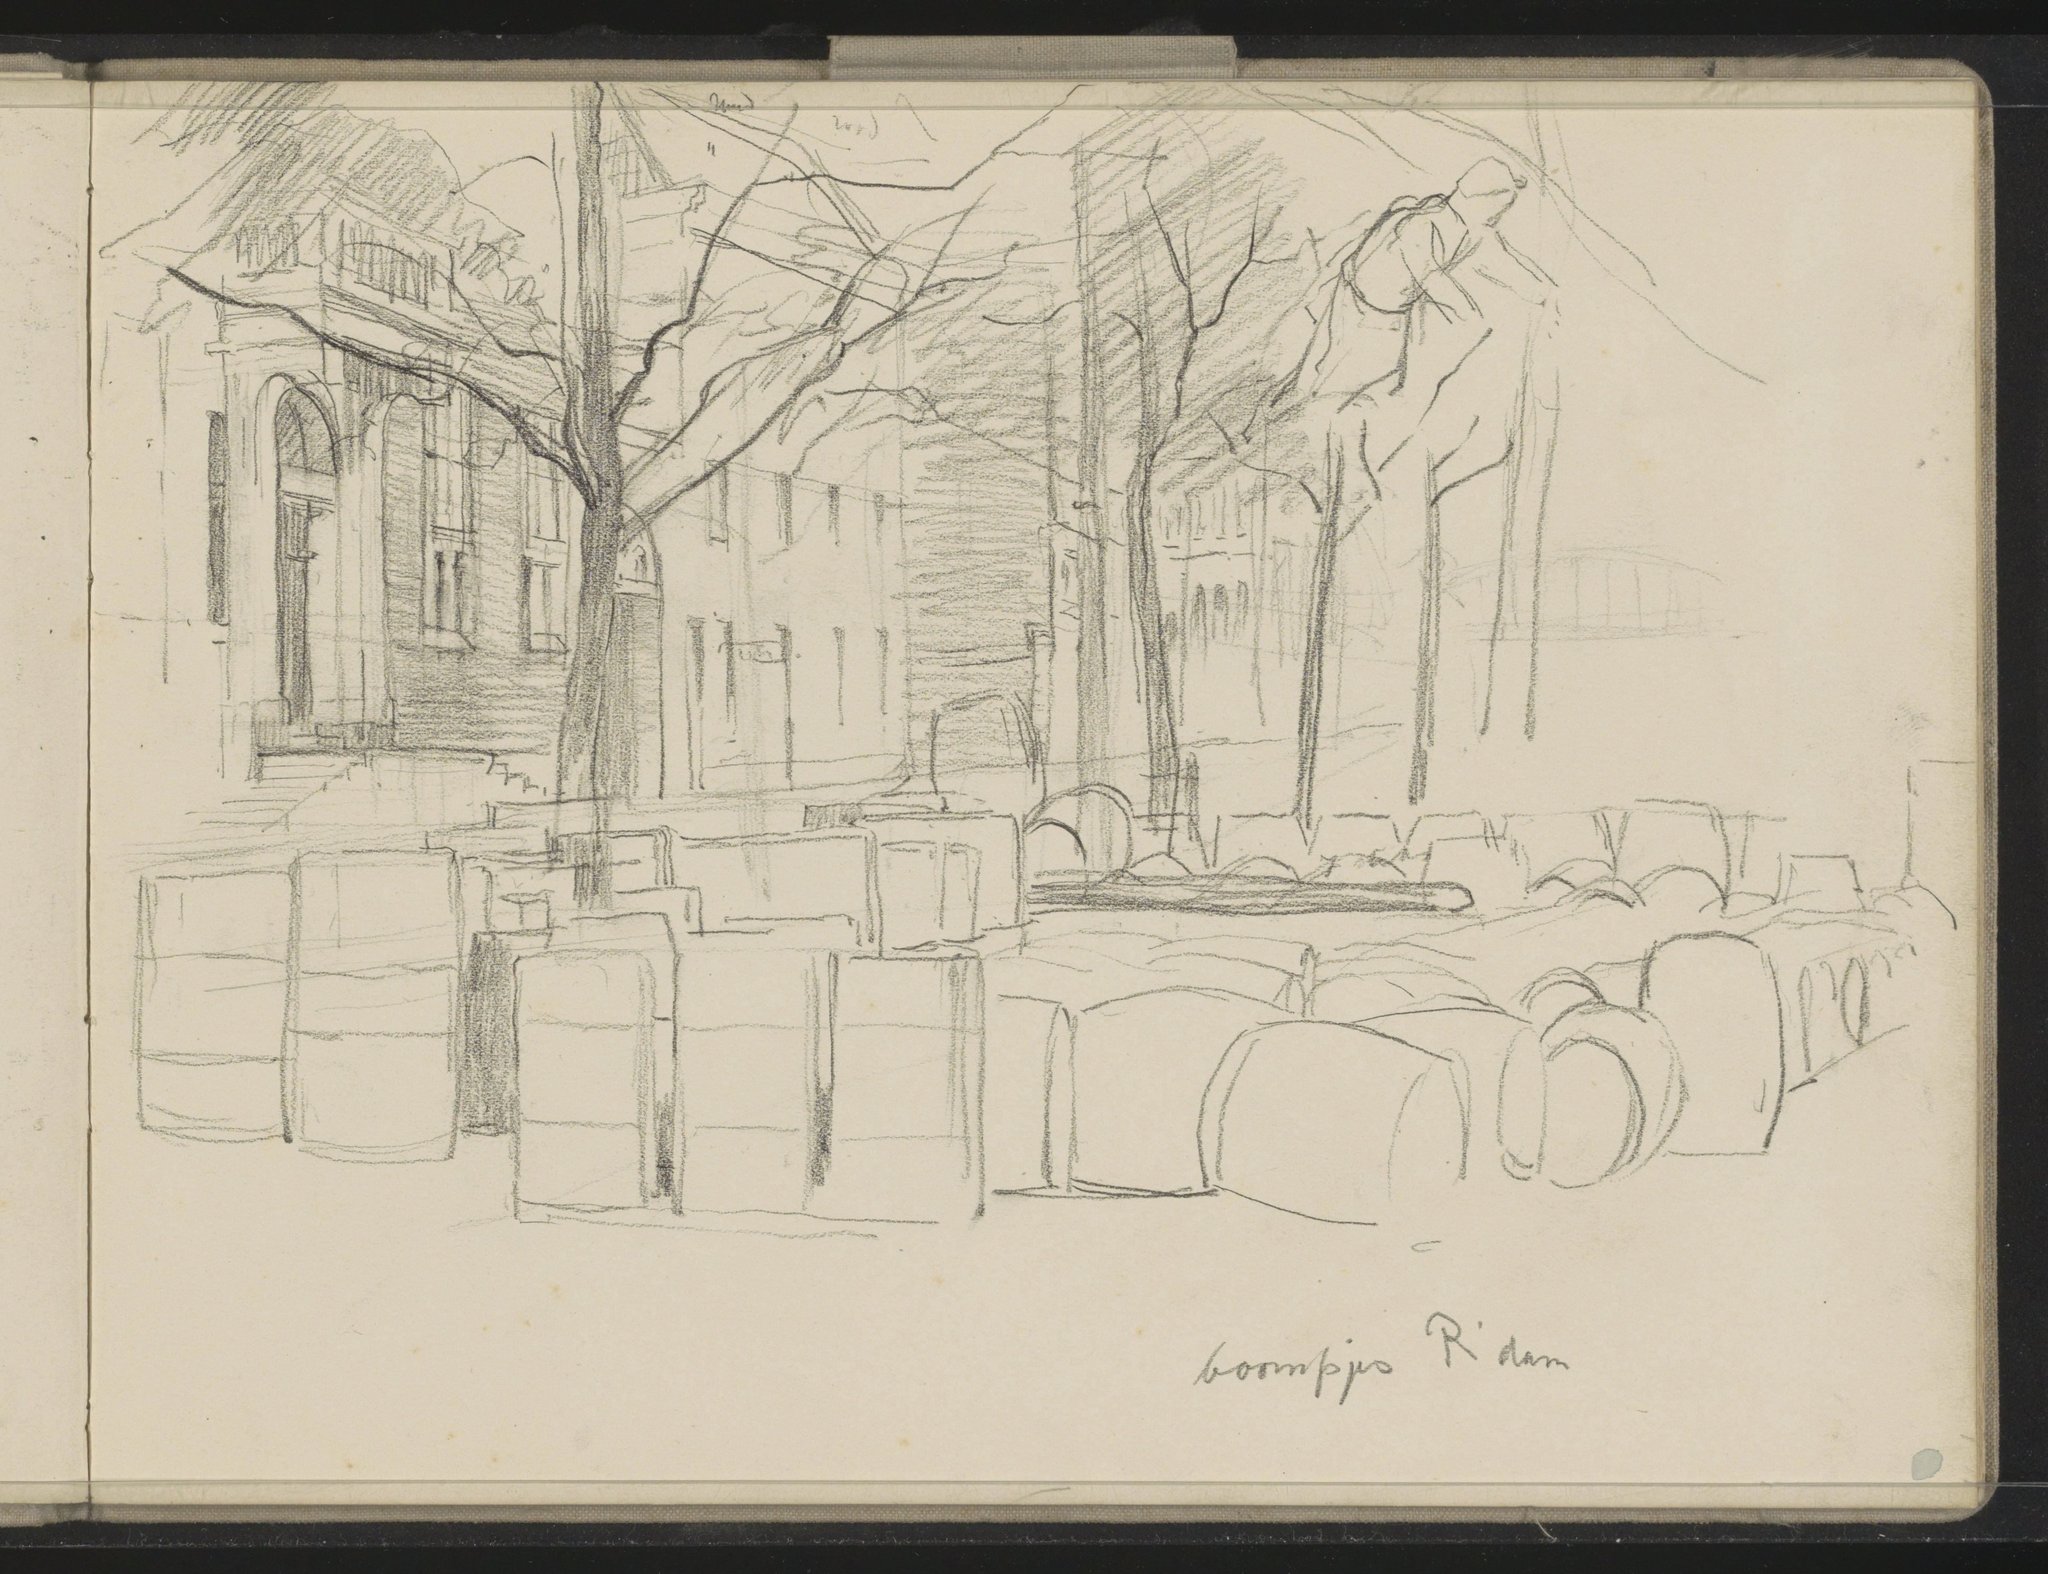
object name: sketchbook leaf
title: De Boompjes te Rotterdam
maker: ferdinand oldewelt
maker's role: draughtsman, print maker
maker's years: 1857-1935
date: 1908-1923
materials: chalk, paper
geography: rotterdam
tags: wooden container: barrel, cask, bucket, avenue, boulevard, promenade, esplanade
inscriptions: annotation: ‘boompjes R'dam’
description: Op de promenade langs de bomen staan en liggen vaten. Blad 18 recto uit een schetsboek met 35 bladen.